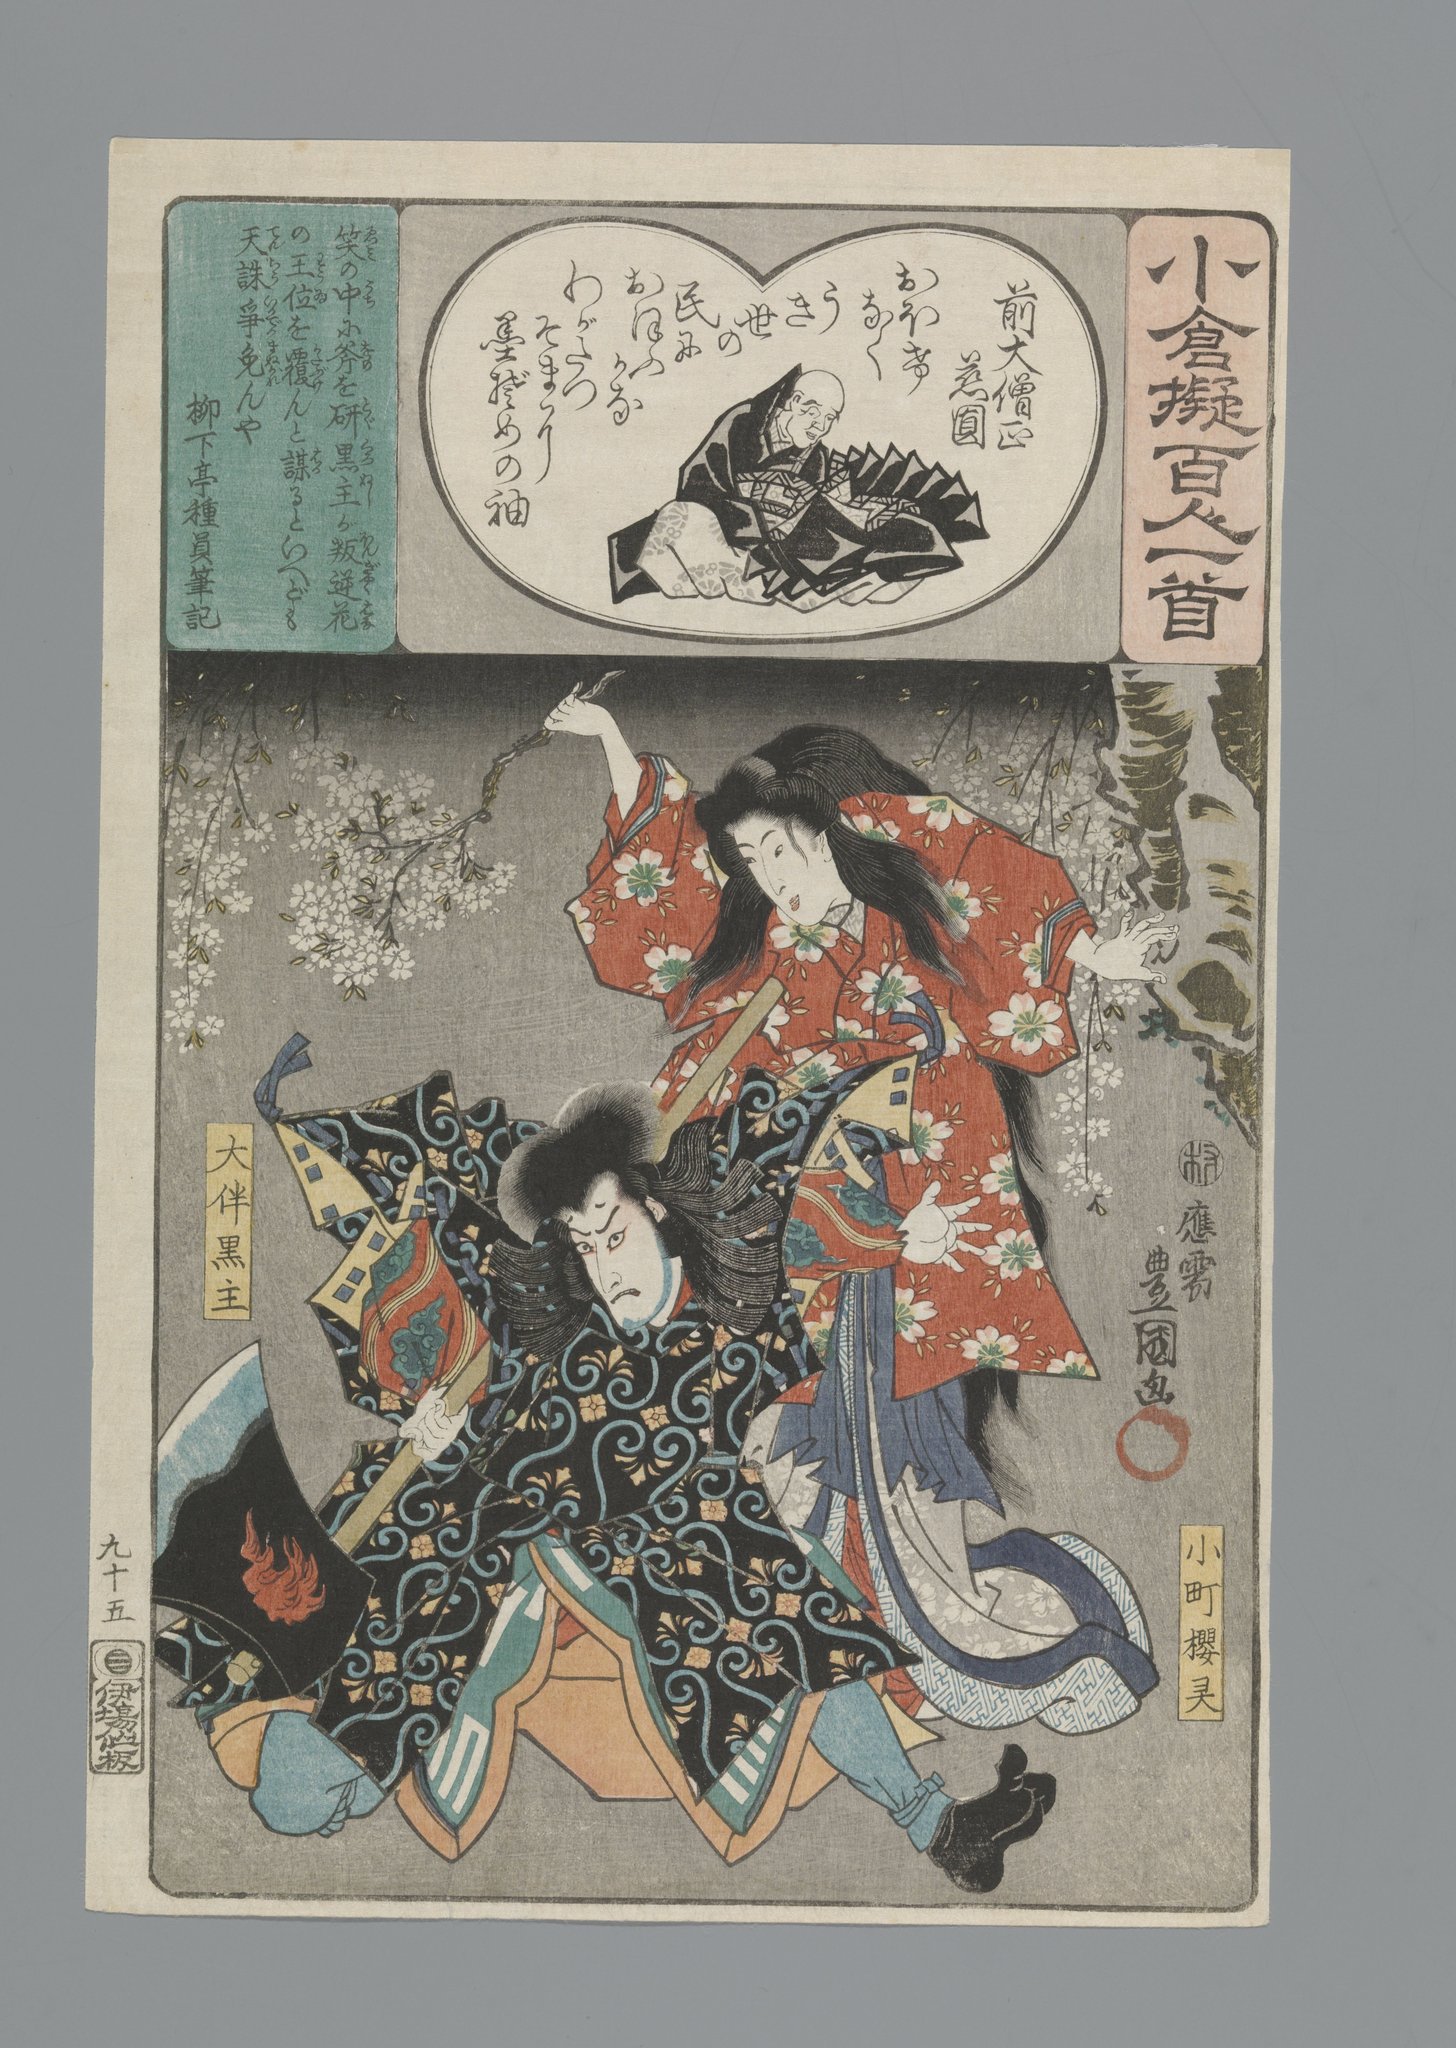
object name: print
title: Saki no Dai-Sojô Jien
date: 1846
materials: paper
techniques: woodcut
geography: japan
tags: courtesan, hetaera, actor (on the stage), spirit, ghost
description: De geest van de kersenboom, Sumizome, in de vorm van een courtisane, met een bloesemtak in haar hand. Ze staat op het punt de hoveling Kuronushi met de tak op zijn hoofd te slaan, omdat hij de kersenboom om wilde hakken. Deze toneelscene verbeeldt de rivaliteit tussen twee beroemde dichters; Otomo no Kuronushi (met bijl) en de vrouwelijke dichter Ono no Komachi. Scene uit een kabukitoneelstuk. Gedicht door Saki no Dai-Sojô Jien.